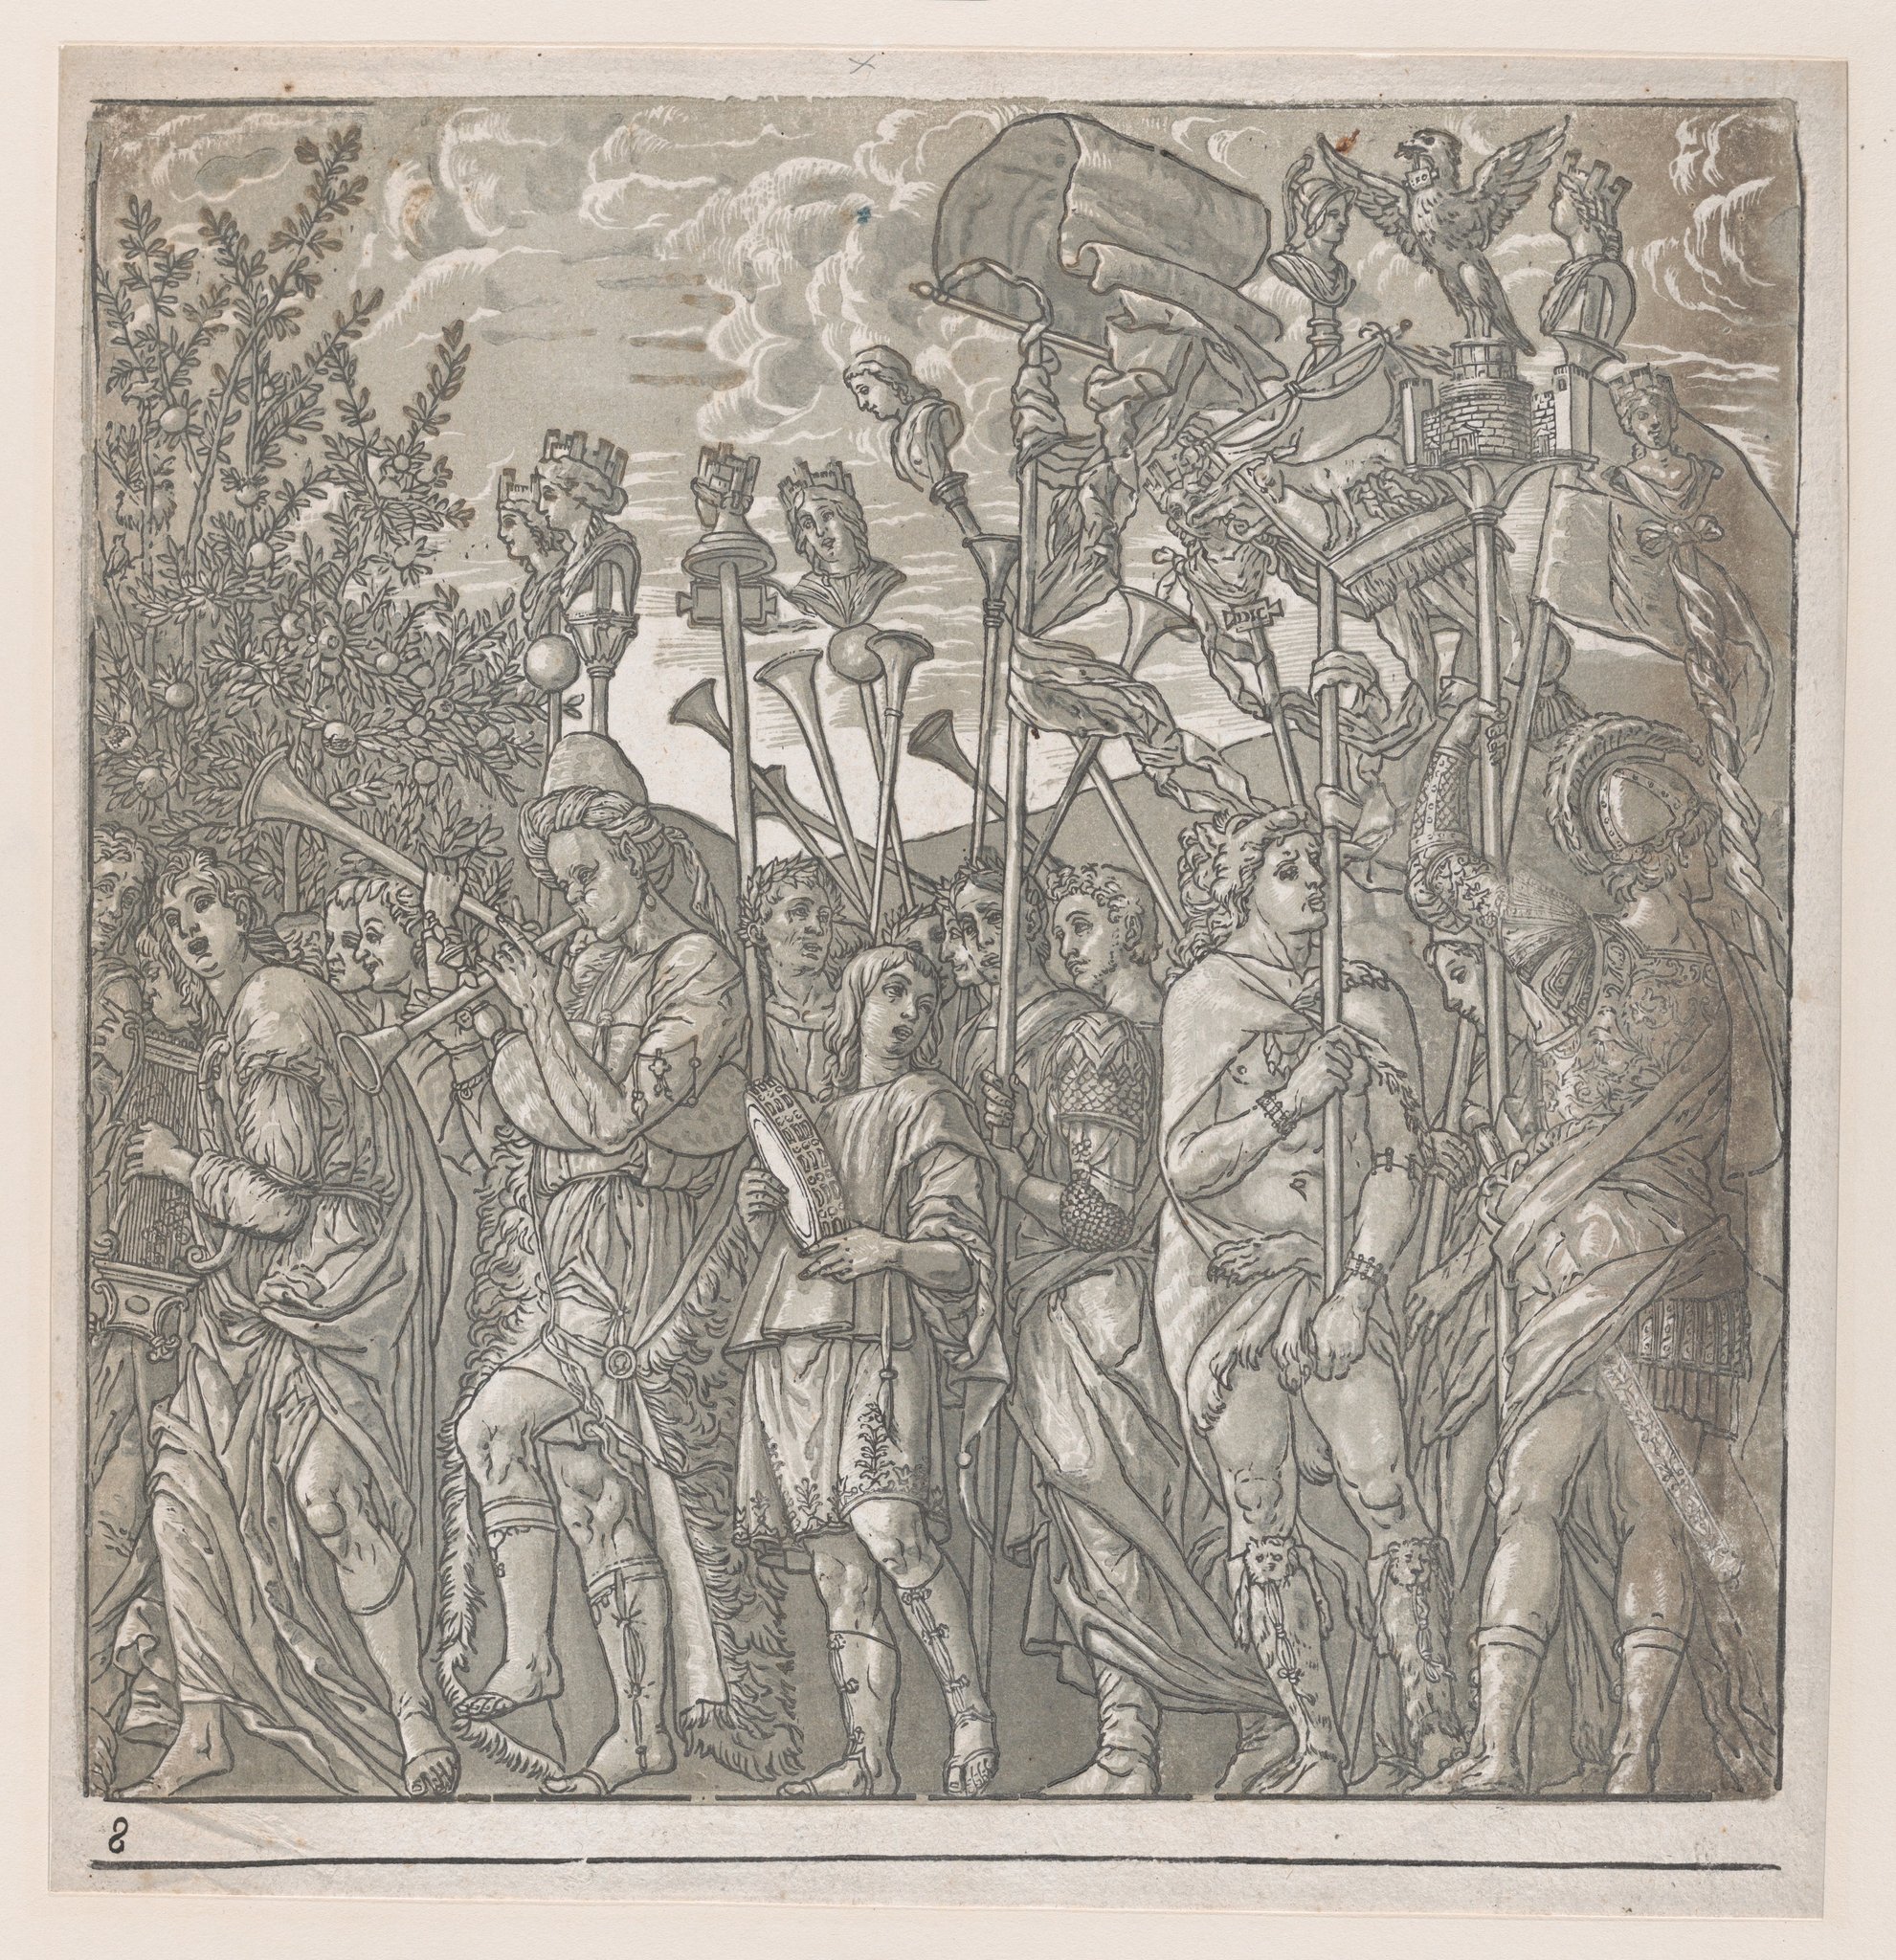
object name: print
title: Sheet 8: Procession of Musicians, from "The Triumph of Julius Caesar"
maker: andrea andreani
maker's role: artist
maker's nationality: italian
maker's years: 1558-1629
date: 1599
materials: ink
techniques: woodcut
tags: musical instruments,men,drums,flags,musicians